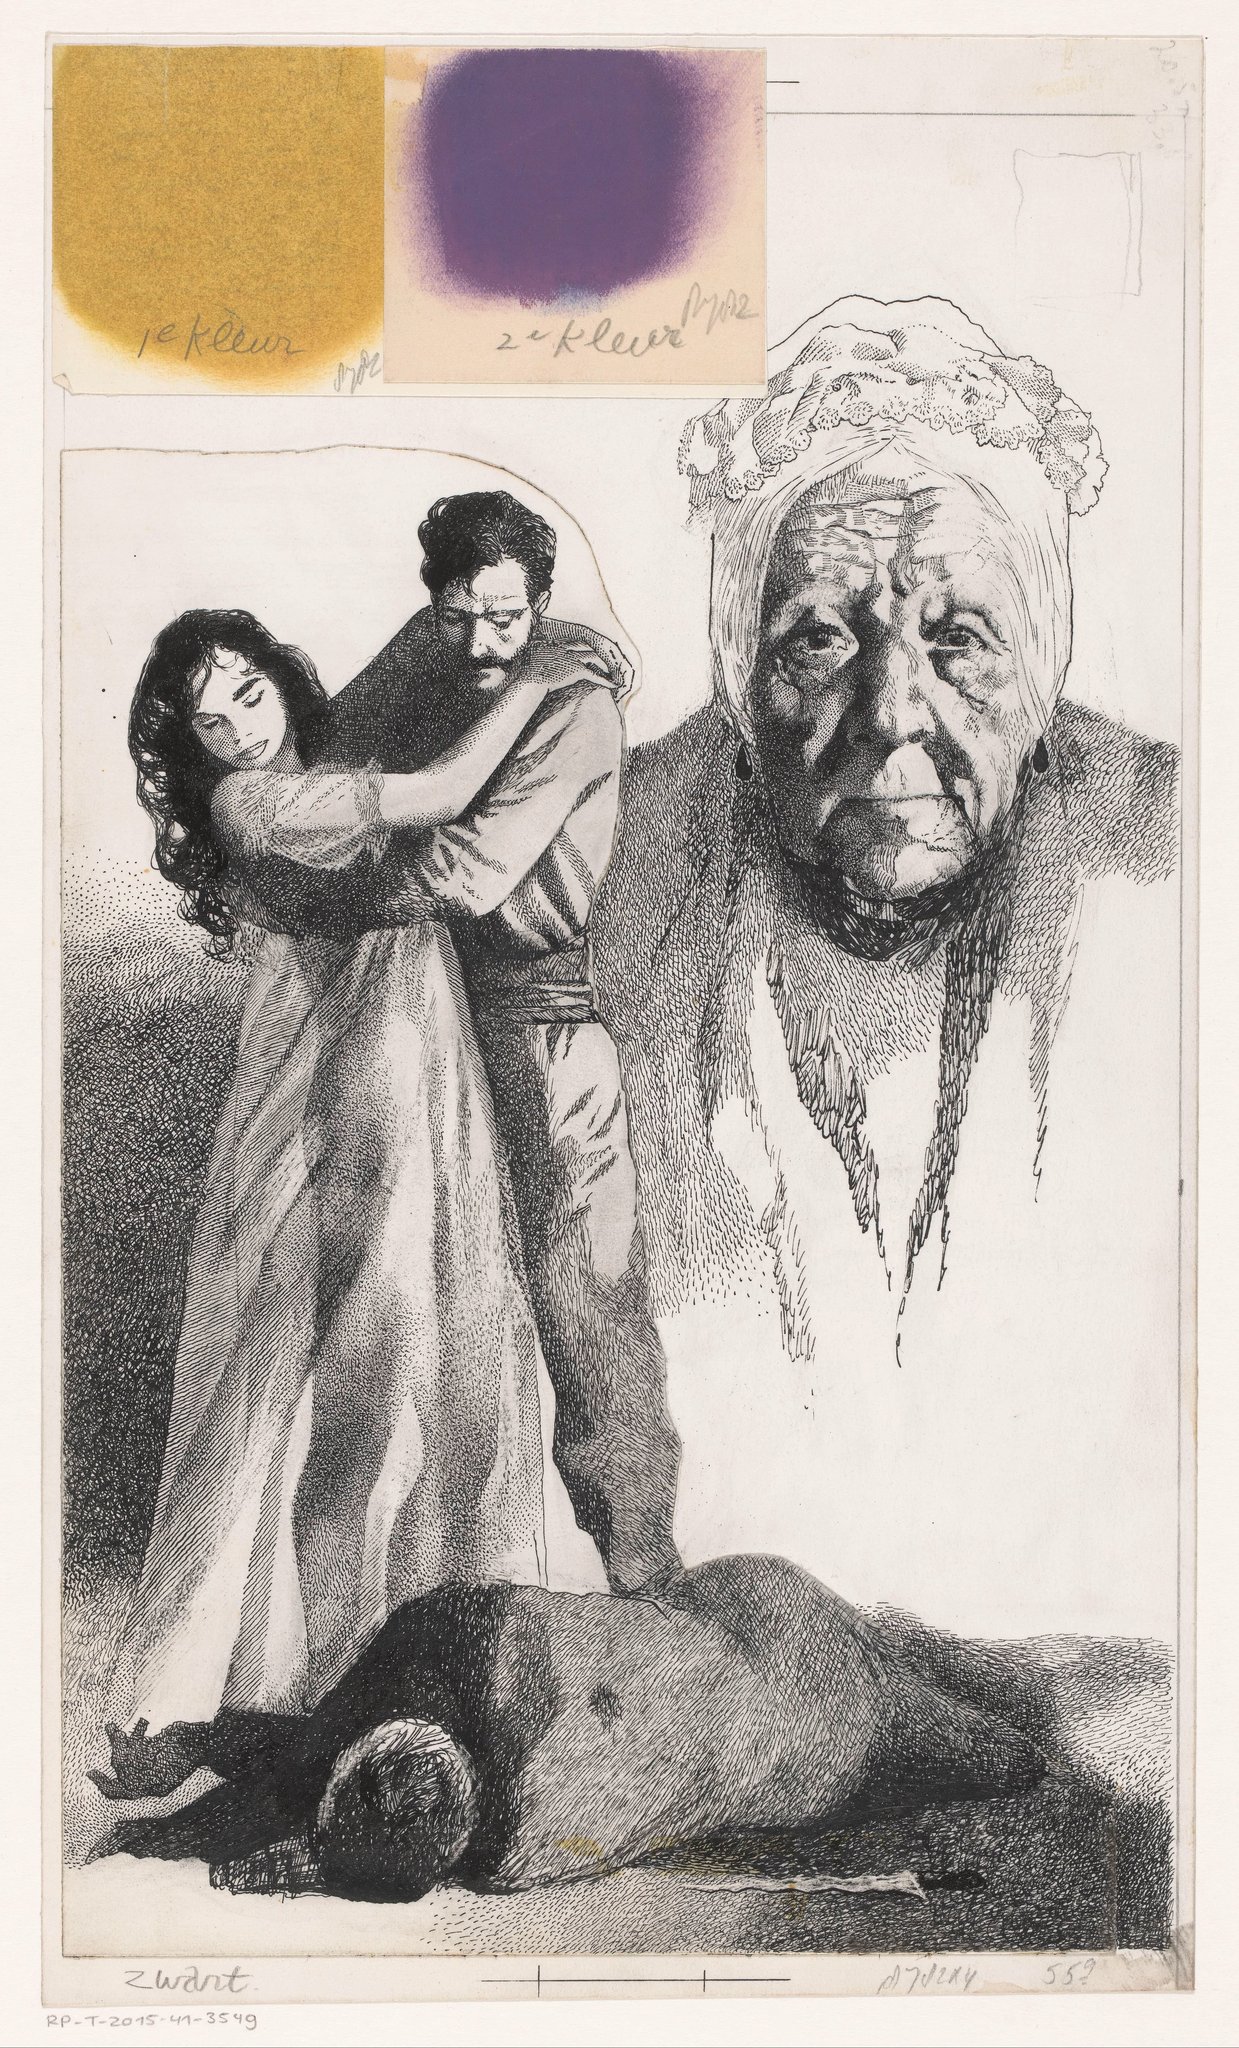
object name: study for binding design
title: Bandontwerp voor: Louis Couperus, Van oude menschen, de dingen die voorbijgaan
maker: Anonymous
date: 1906-1970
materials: ink, paint, paper, pencil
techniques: brush, pen, snipping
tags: (lovers) embracing each other, 'symplegma', old woman, murder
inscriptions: collector's mark: Lugt 2228a, annotation: ‘van Oude Mensen/ de dingen die/ voorbijgaan./ A. Anne Tadema?’, :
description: De jonge Ottilie Dercksz omhelst haar minnaar Emile Takma. Het stel kijkt naar de grond, waar generaal Dercksz, de echtgenoot van Ottilie, dood op de grond ligt naast een mes. In de achtergrond het portret van de oudere Ottilie met een kanten muts op het hoofd. Bij het ontwerp zijn twee kleurstalen gevoegd.